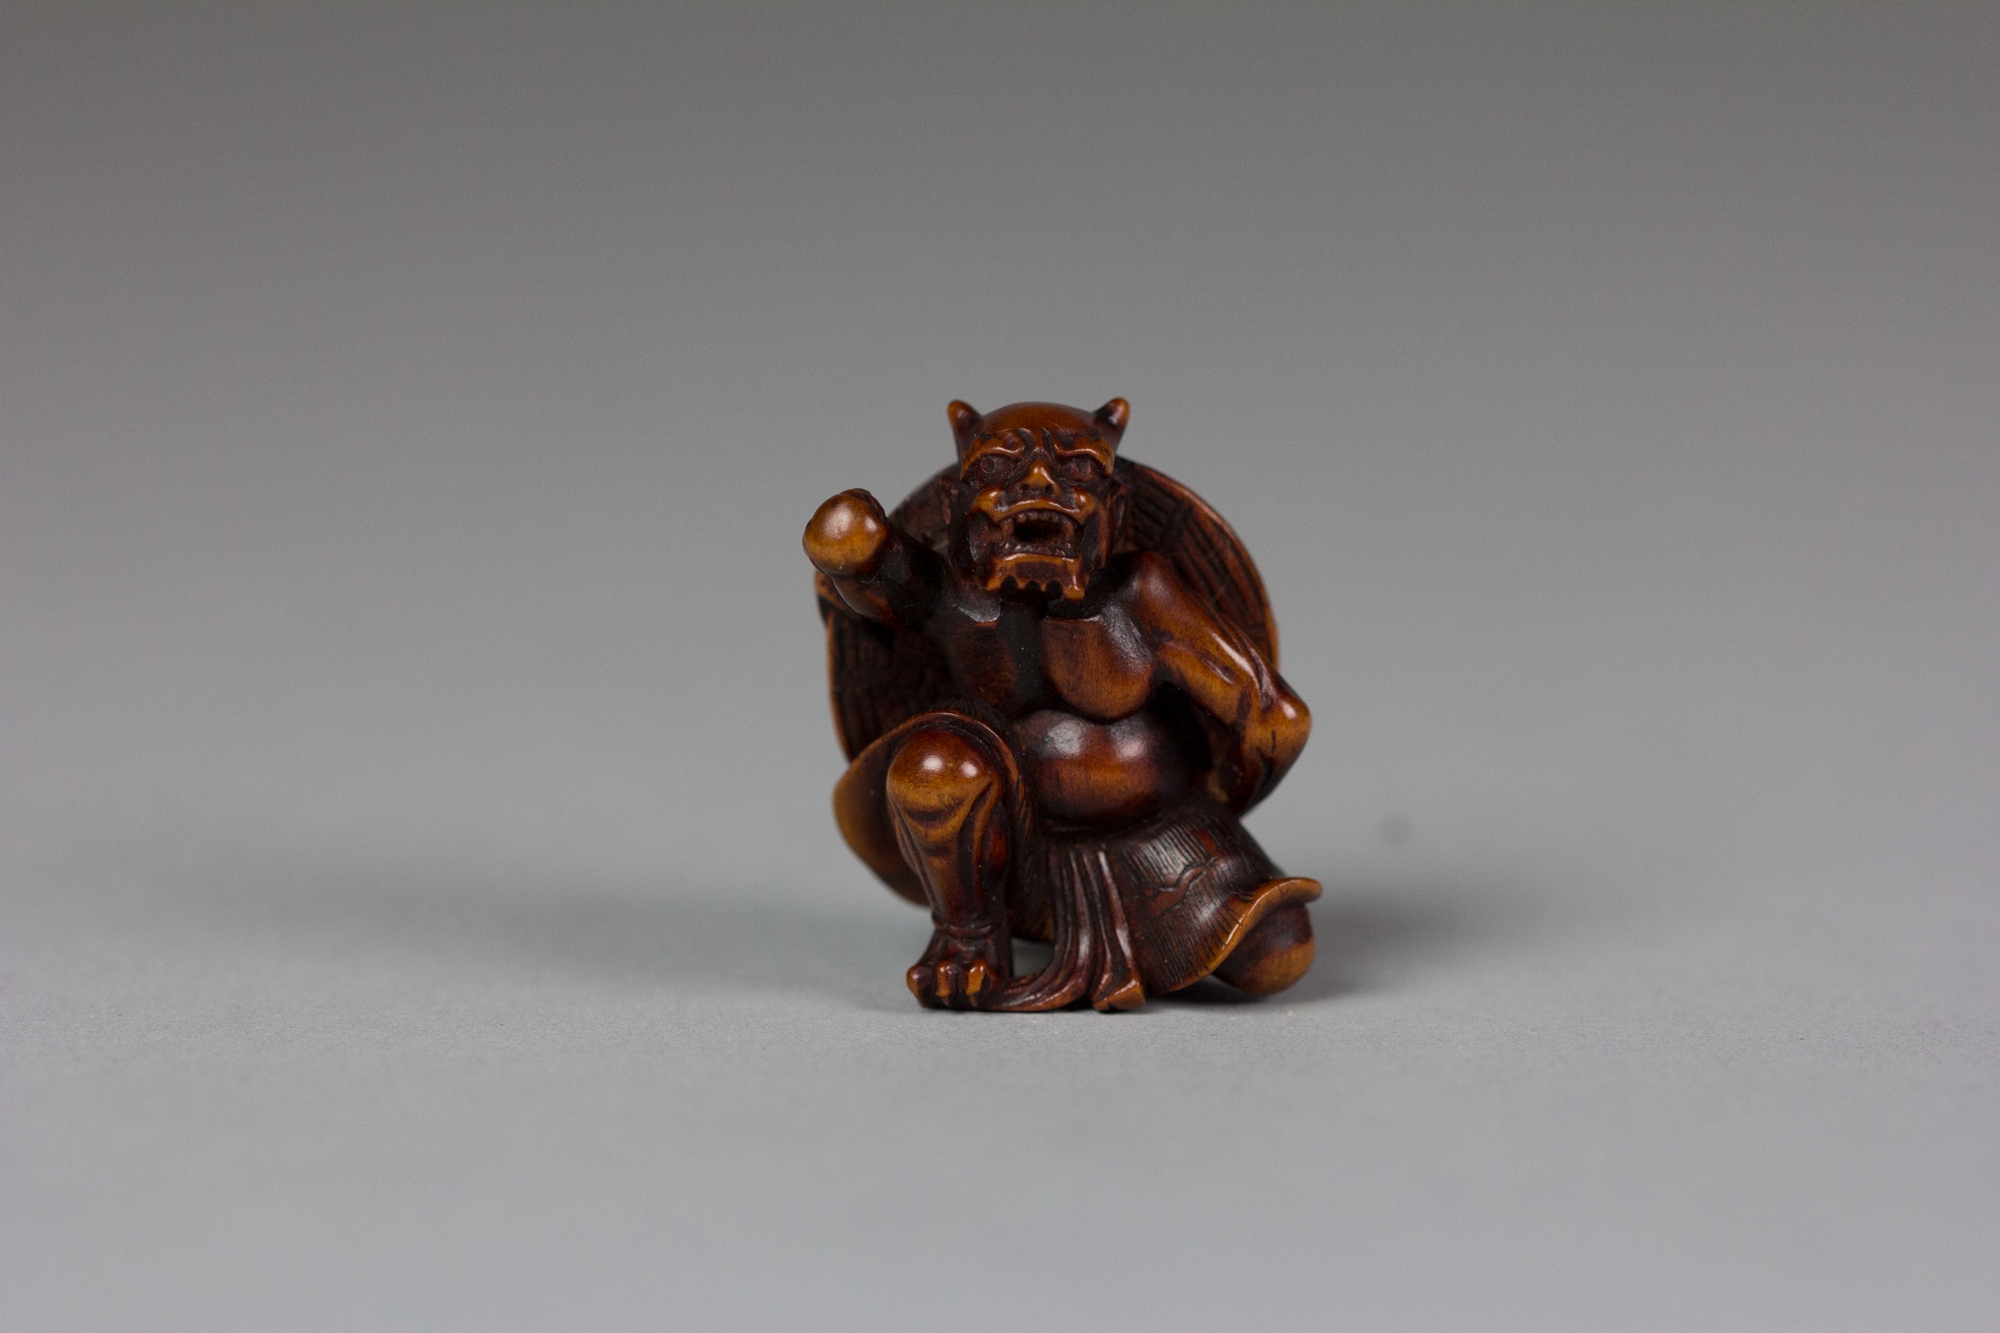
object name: netsuke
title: Netsuke of Demon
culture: japanese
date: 1801-1900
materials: wood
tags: demons